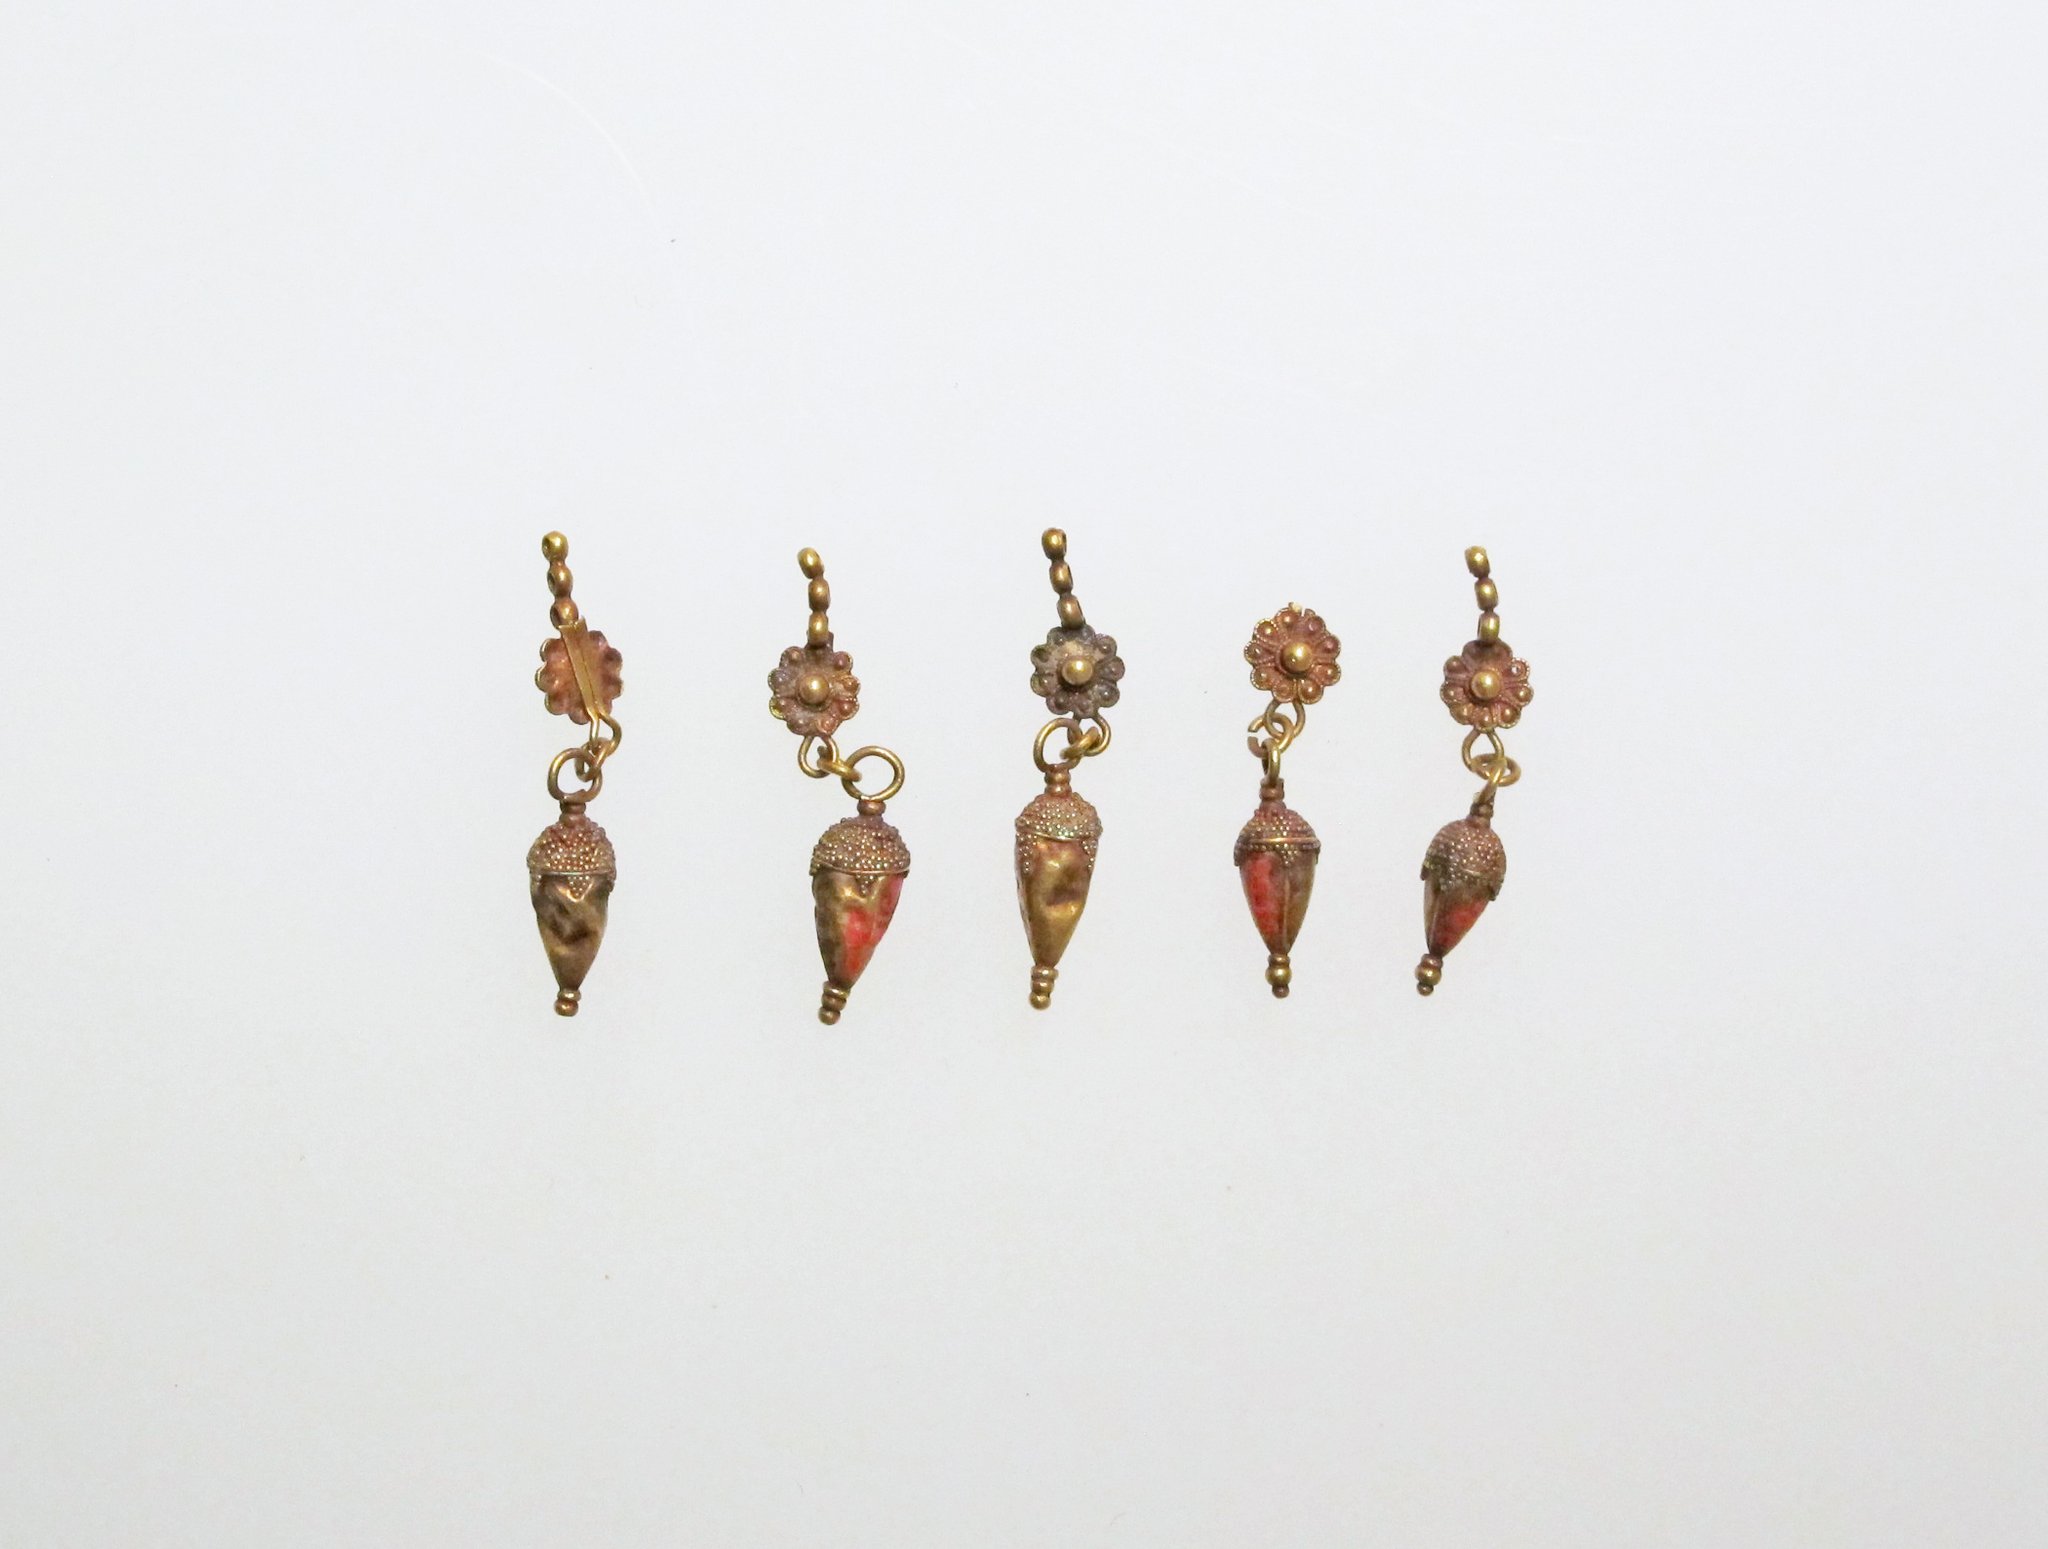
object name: pendant in the form of a rosette with acorn, 5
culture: greek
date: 7000-30 BCE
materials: gold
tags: acorns